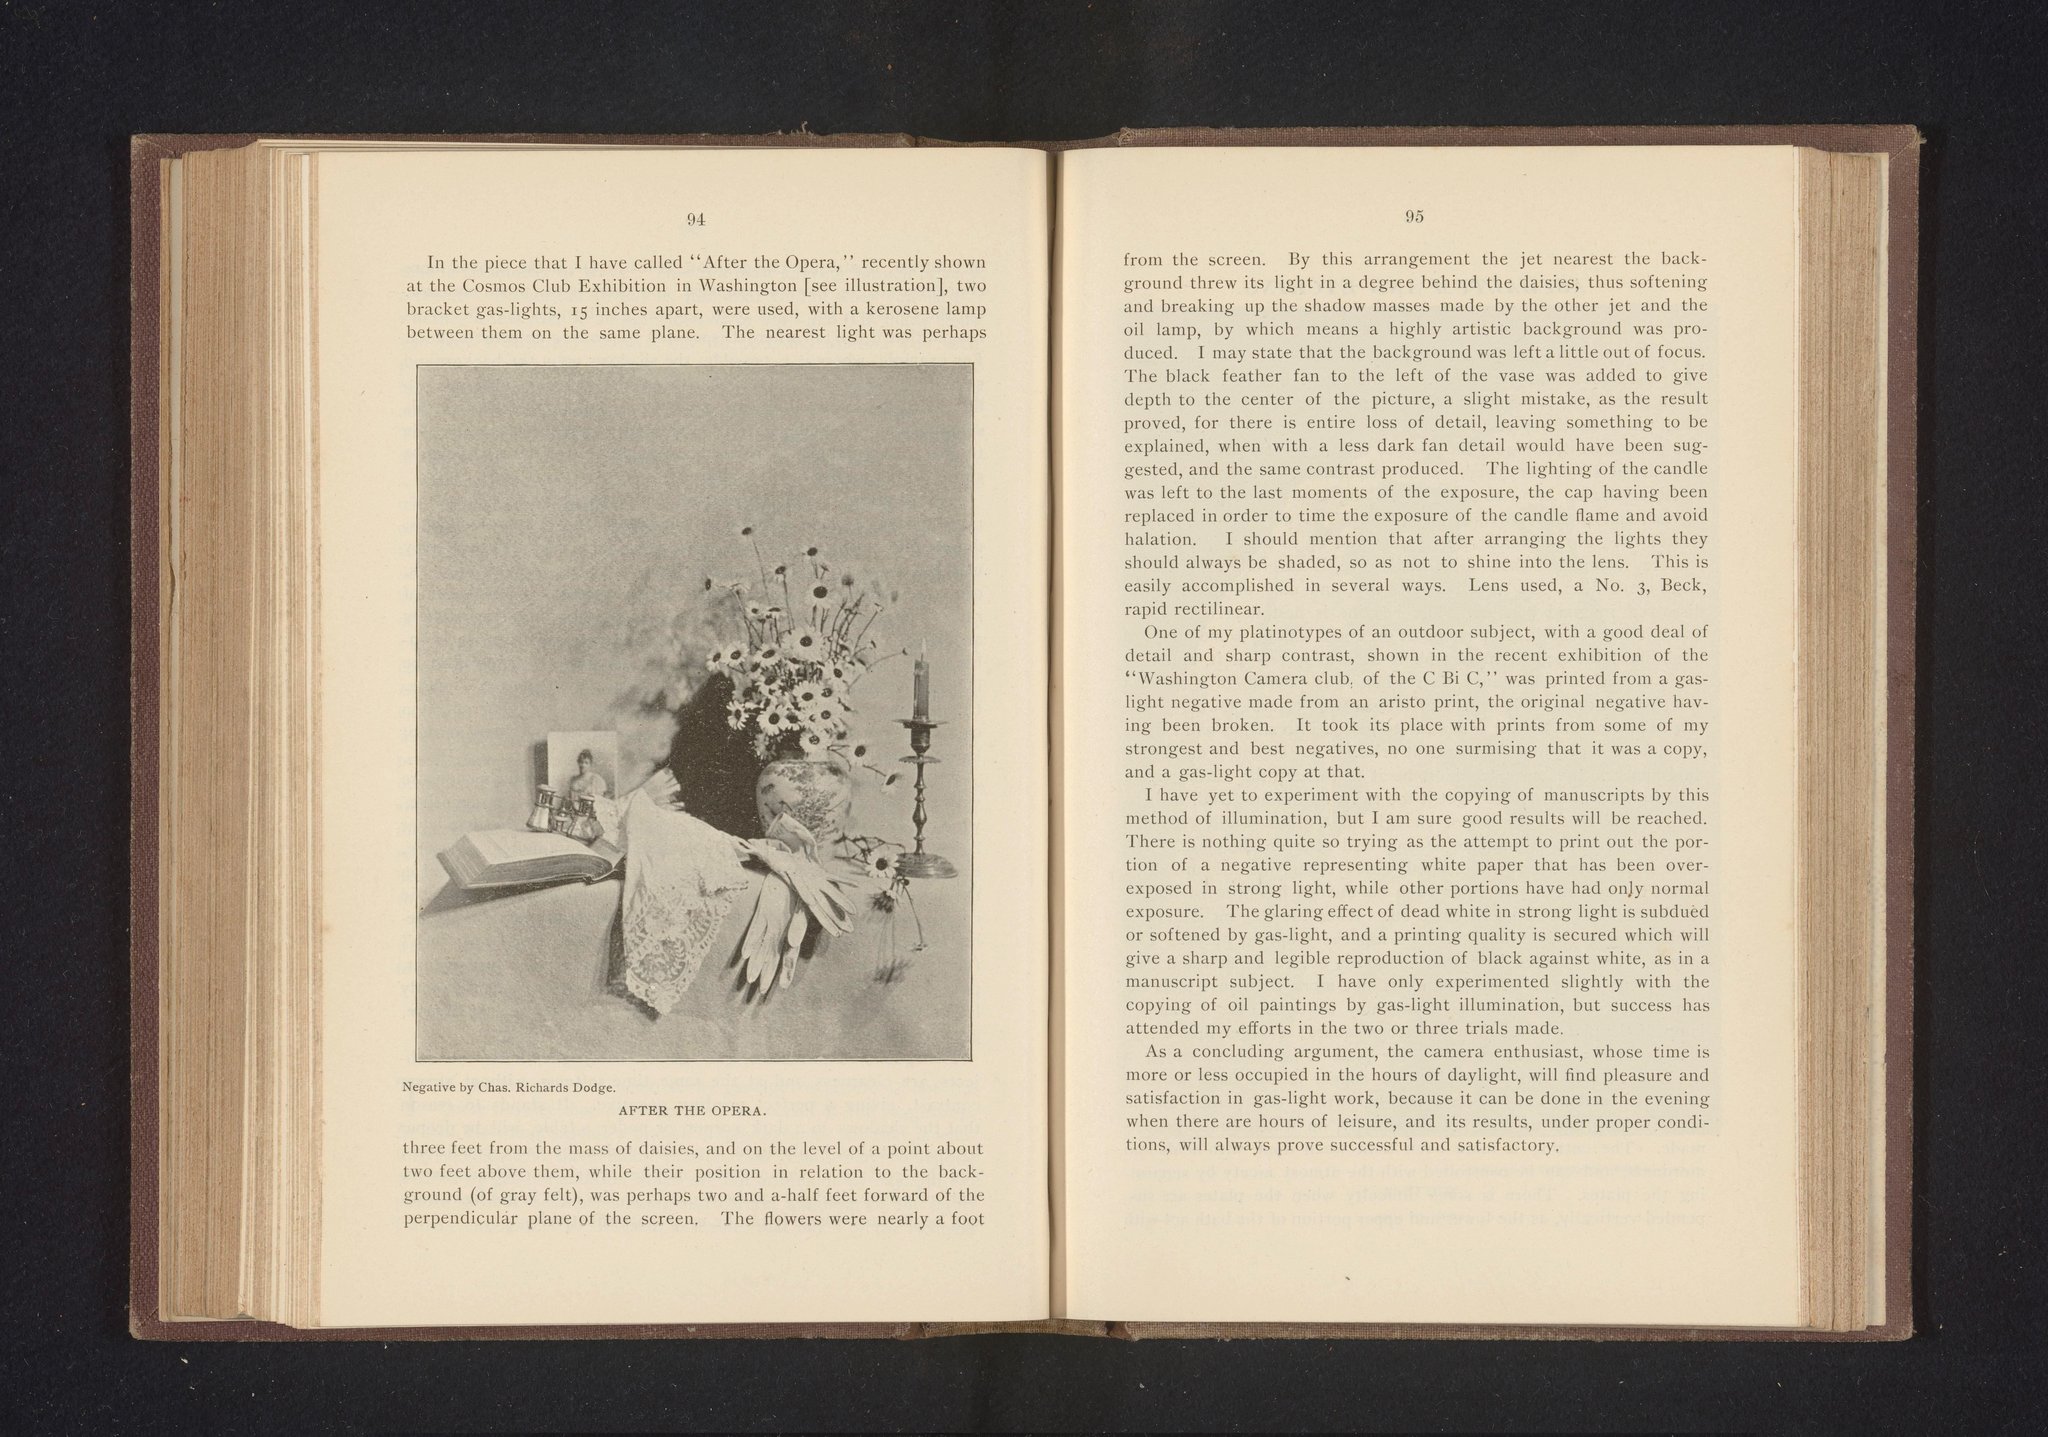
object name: photomechanical print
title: After the opera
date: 1890-1895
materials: paper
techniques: autotype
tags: table, flowers in a vase, binoculars, spy-glass, etc.